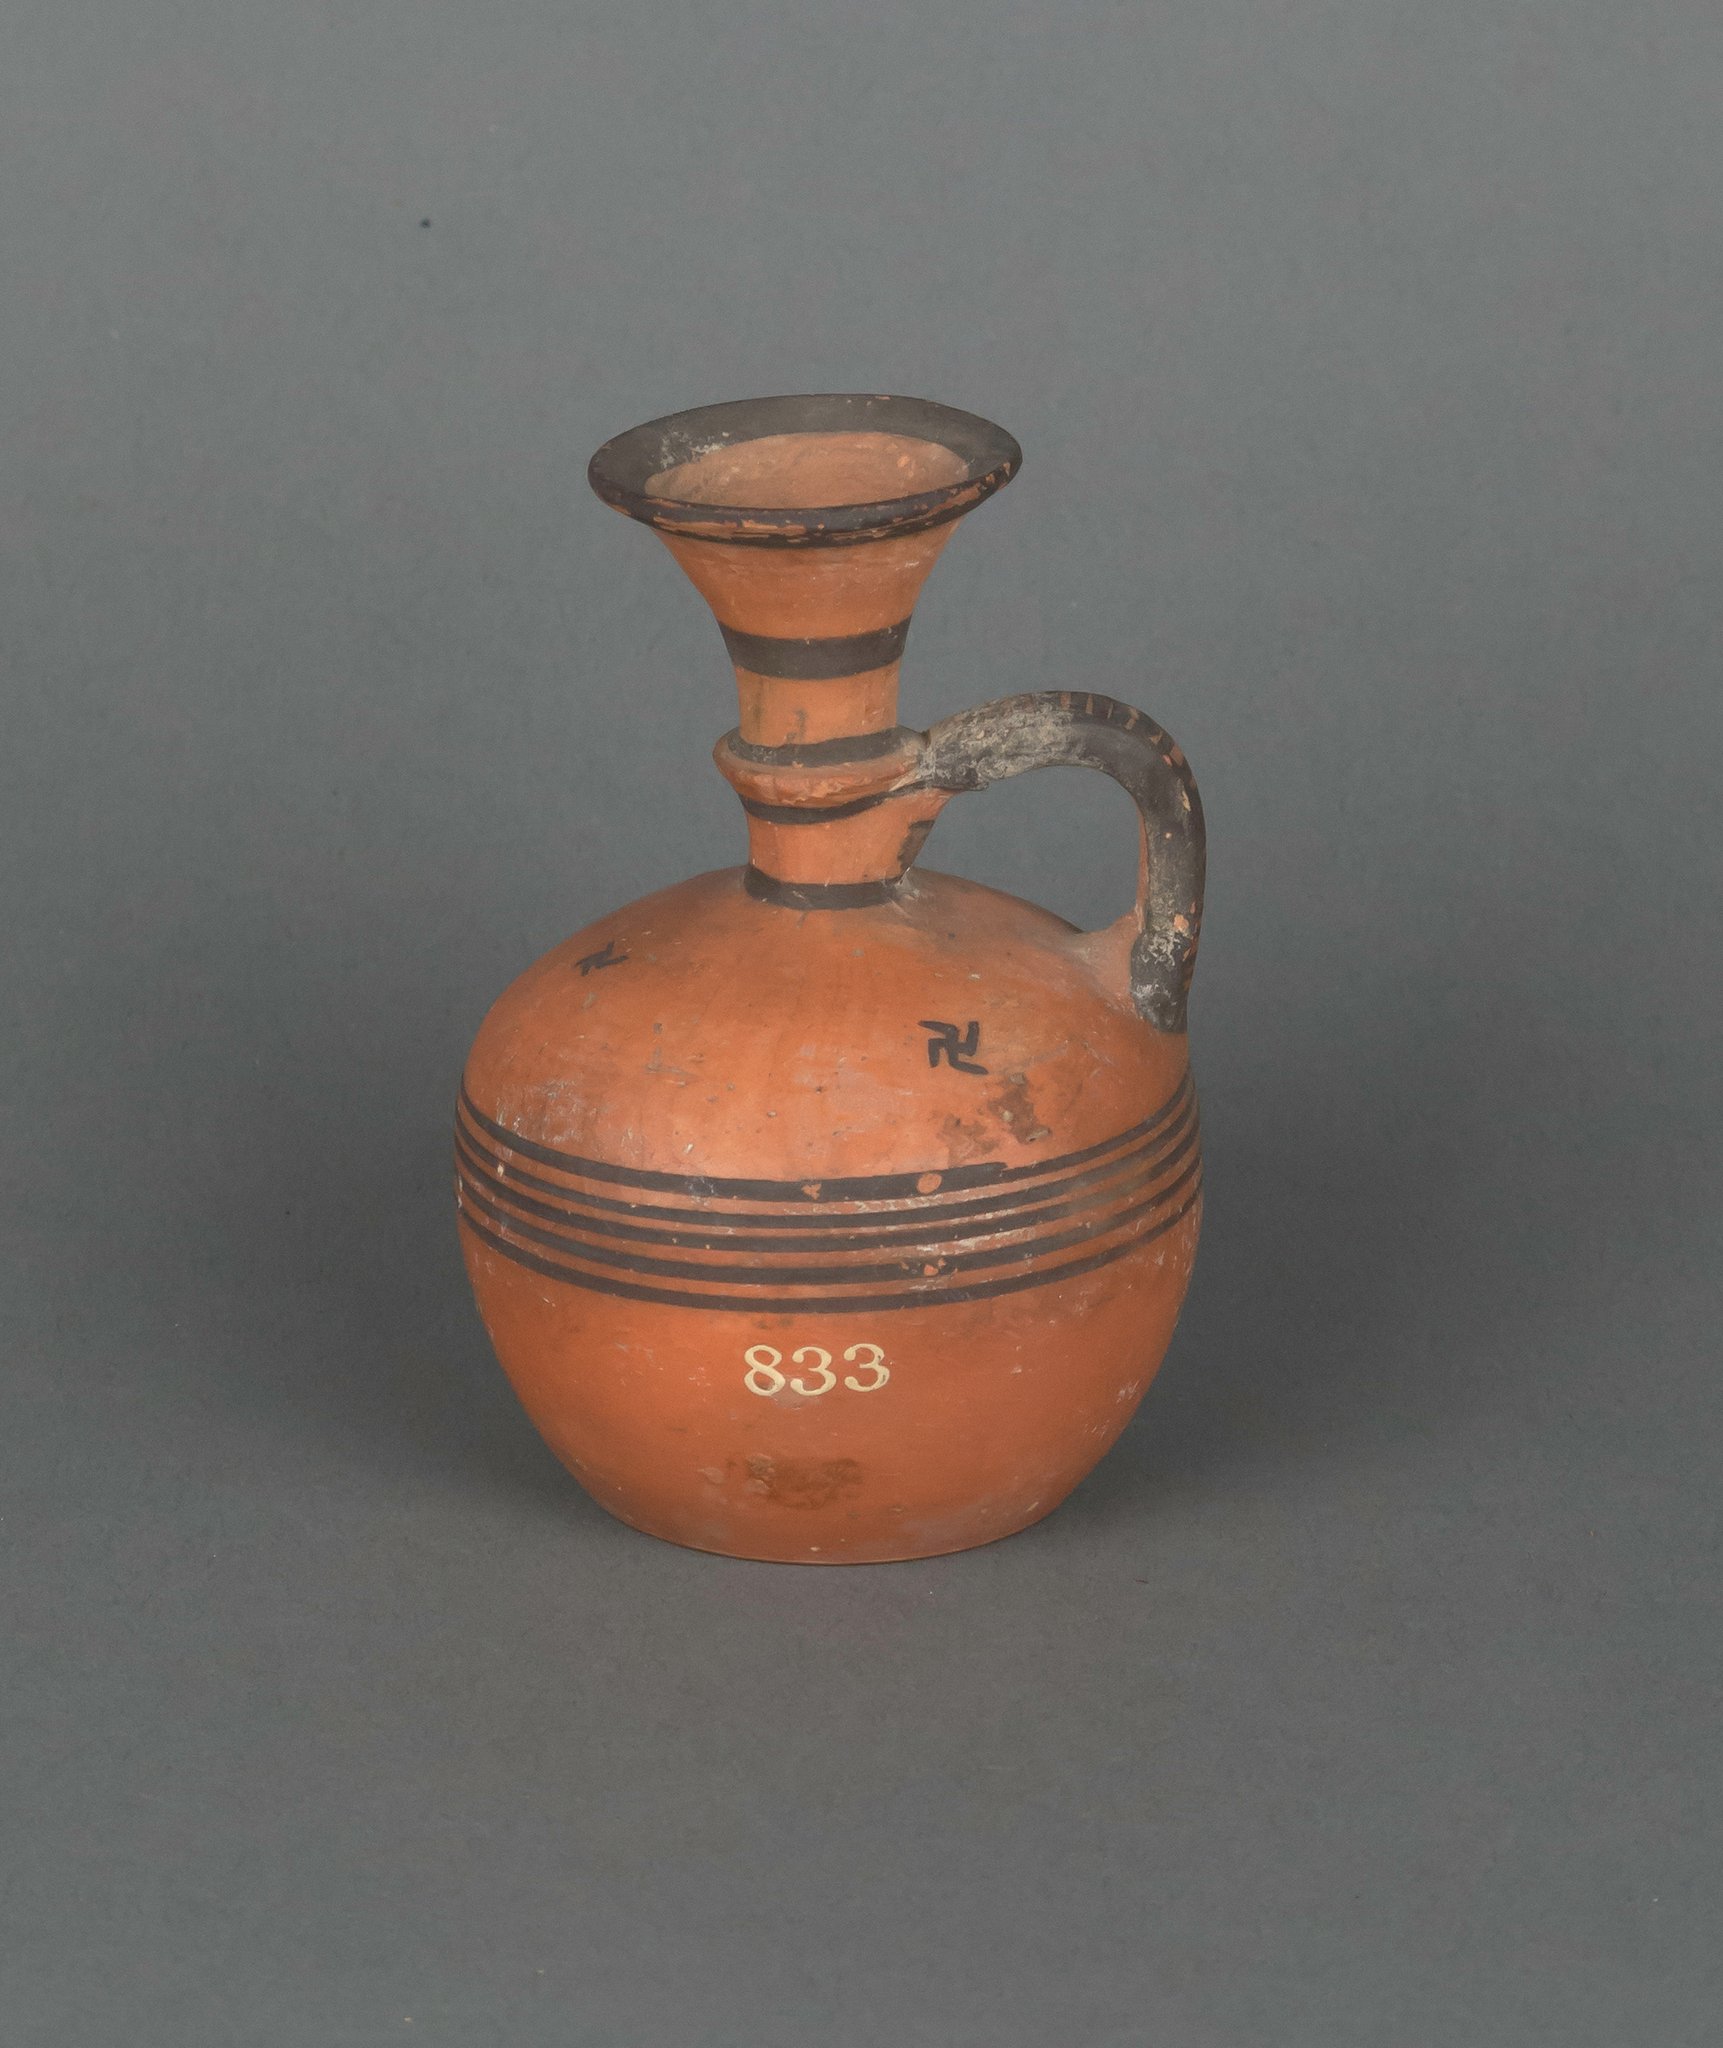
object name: juglet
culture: cypriot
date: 750-600 BCE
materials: terracotta